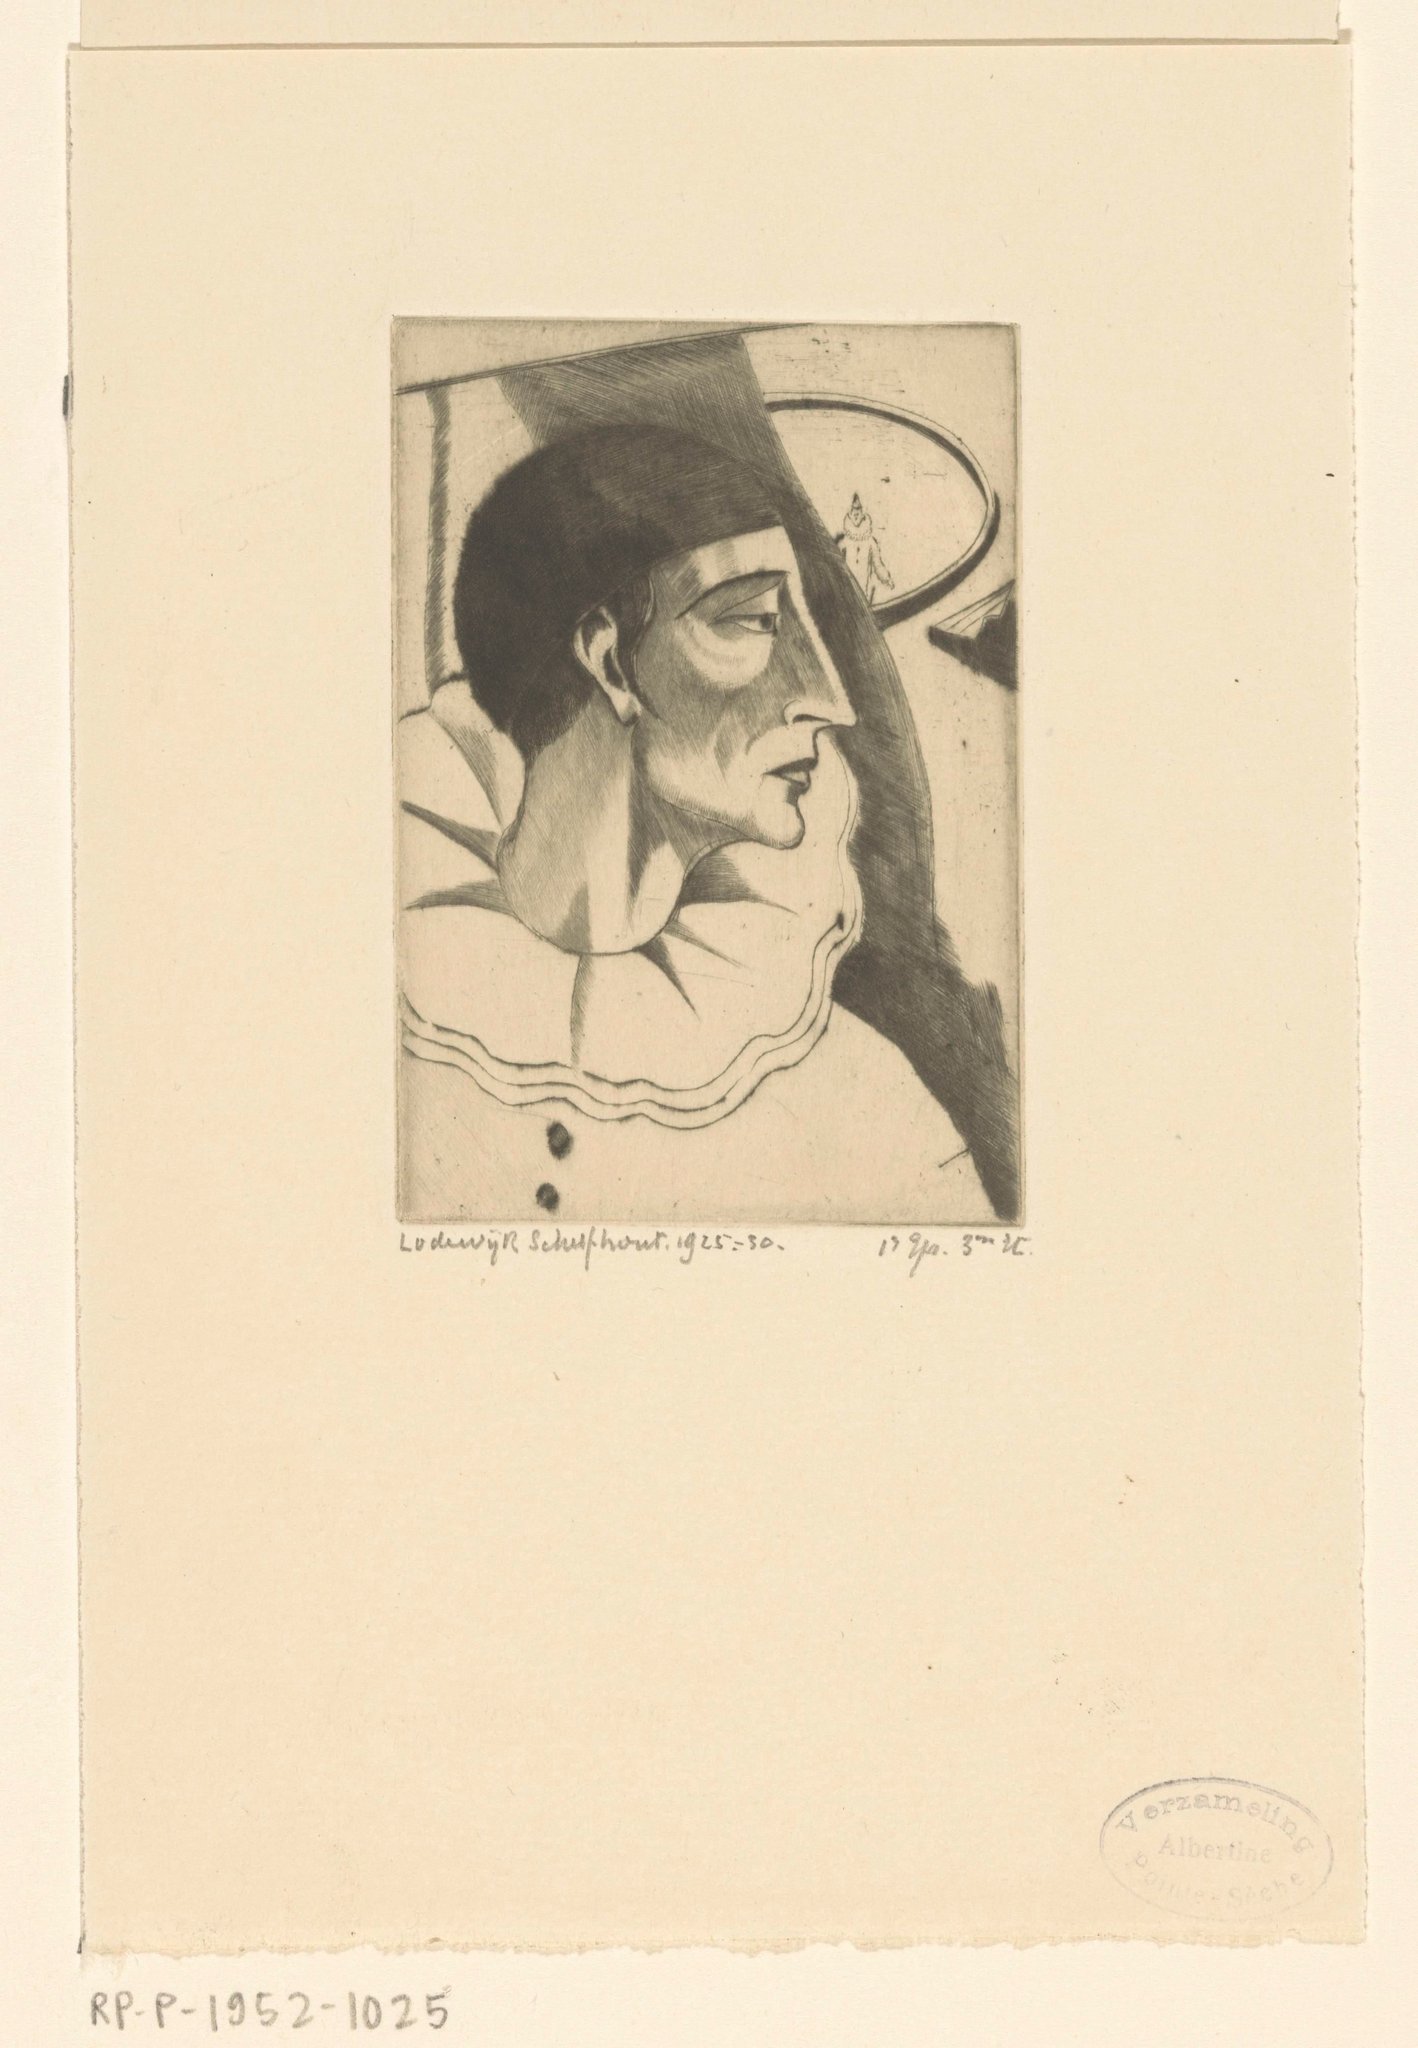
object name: print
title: Pierrot IV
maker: lodewijk schelfhout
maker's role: draughtsman, print maker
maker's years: 1881-1943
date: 1925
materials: paper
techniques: drypoint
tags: types in 'commedia dell'arte': pierrot, circus ring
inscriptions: collector's mark: Lugt 2228, collector's mark: Lugt 2760, collector's mark: Lugt 5i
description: Portret van een pierrot. Op de achtergrond een circuspiste met pierrot.